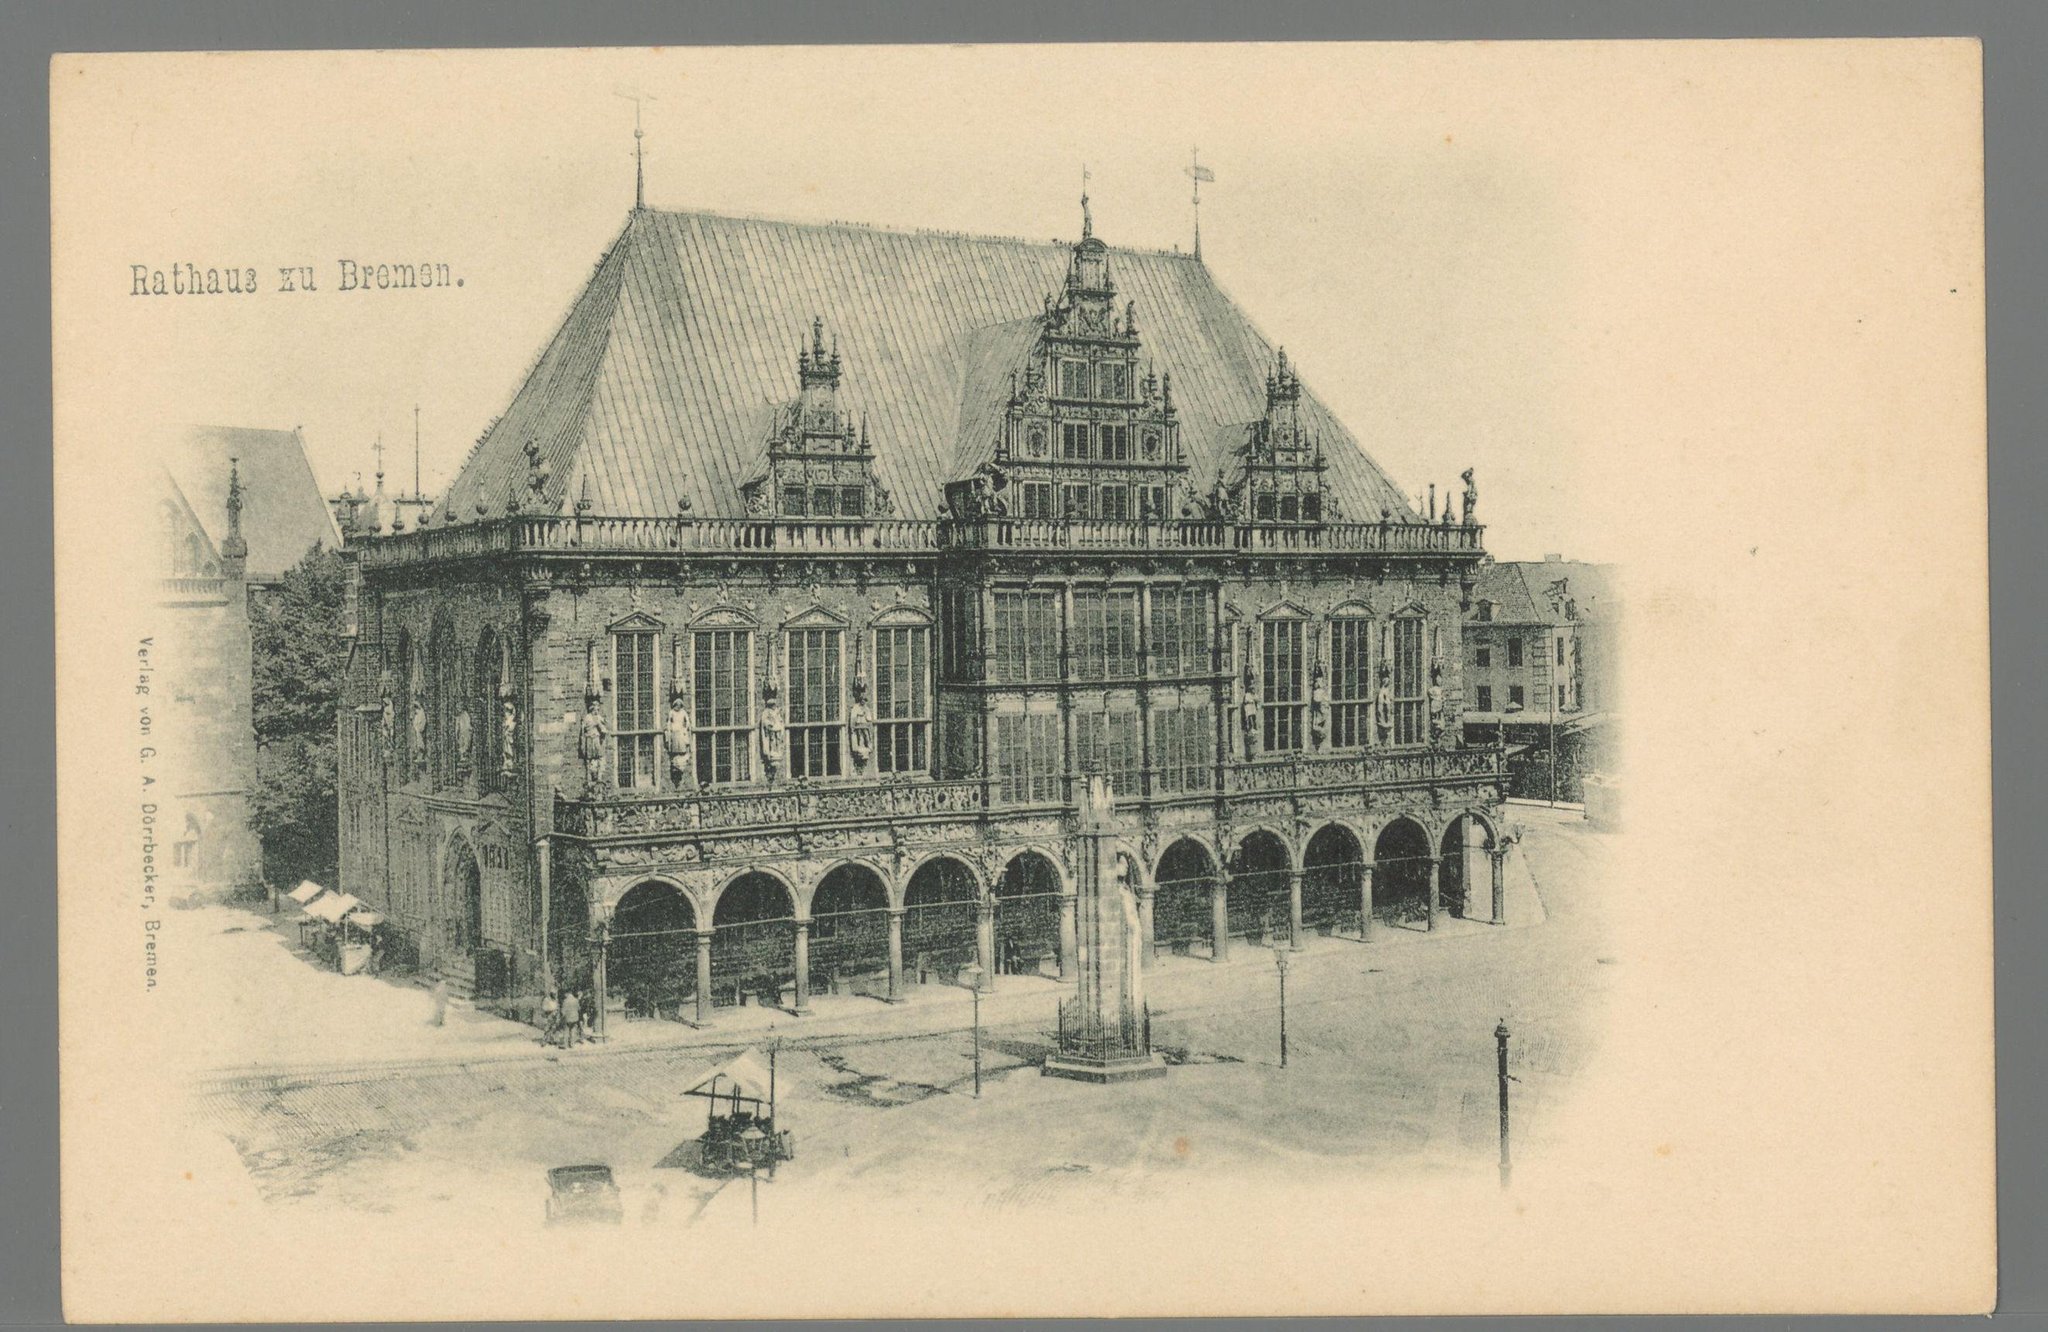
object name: photomechanical print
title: Rathaus zu Bremen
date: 1885-1905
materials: cardboard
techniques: photograph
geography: bremen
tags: townhall